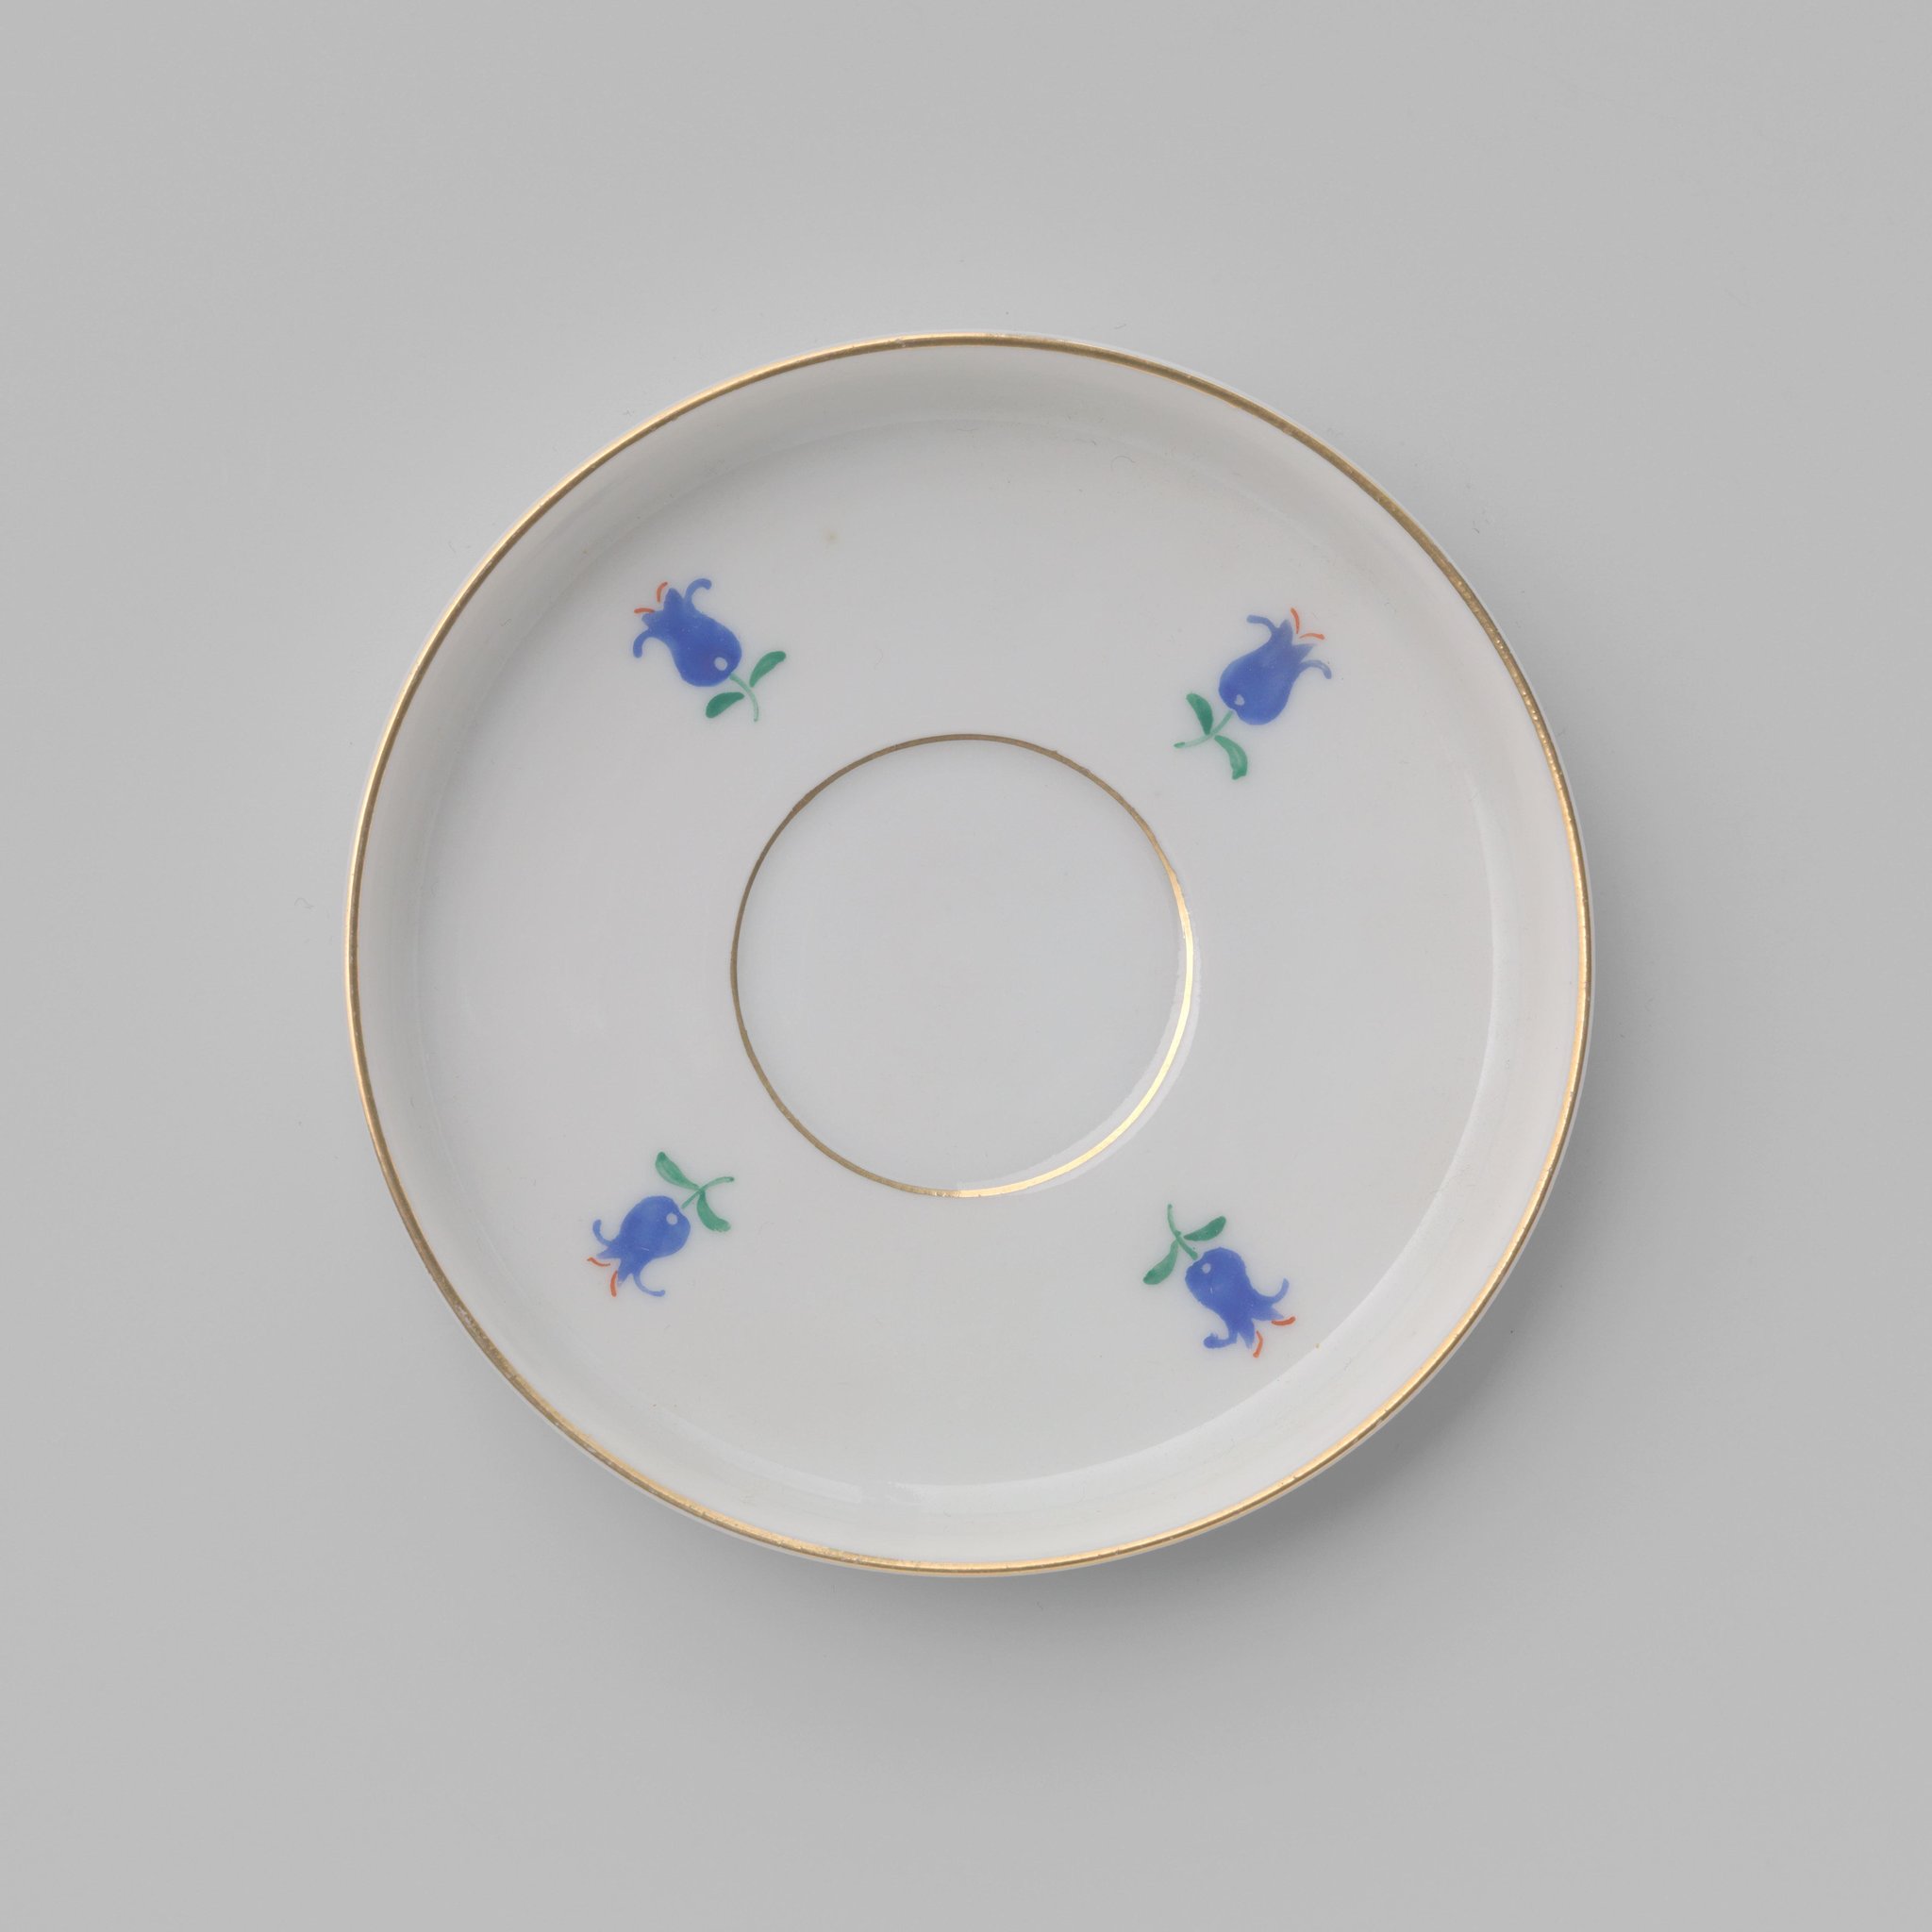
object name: coffee service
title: Saucer bowl with flowers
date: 1935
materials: glaze, gold, paint, porcelain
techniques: firing, forming, gilding, turning, vitrification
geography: karlovy vary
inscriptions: mark: ‘gekruiste hamers met kroon/ EPIAG PIRKENHAMMER CZECHOSLOVAKIA/ 5857’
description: Schotel van porselein met een iets verdiept centrum en lage, opstaande wand, beschilderd op het glazuur in blauw, rood, groen en goud. Op het plat een gouden medaillon om het verdiepte centrum en daaromheen vier blauwe bloemen. Gouden rand. Gemerkt op de onderzijde met de gekruiste hamers met kroon, de tekst 'EPIAG PIRKENHAMMER CZECHOSLOVAKIA' en het nummer 5857.